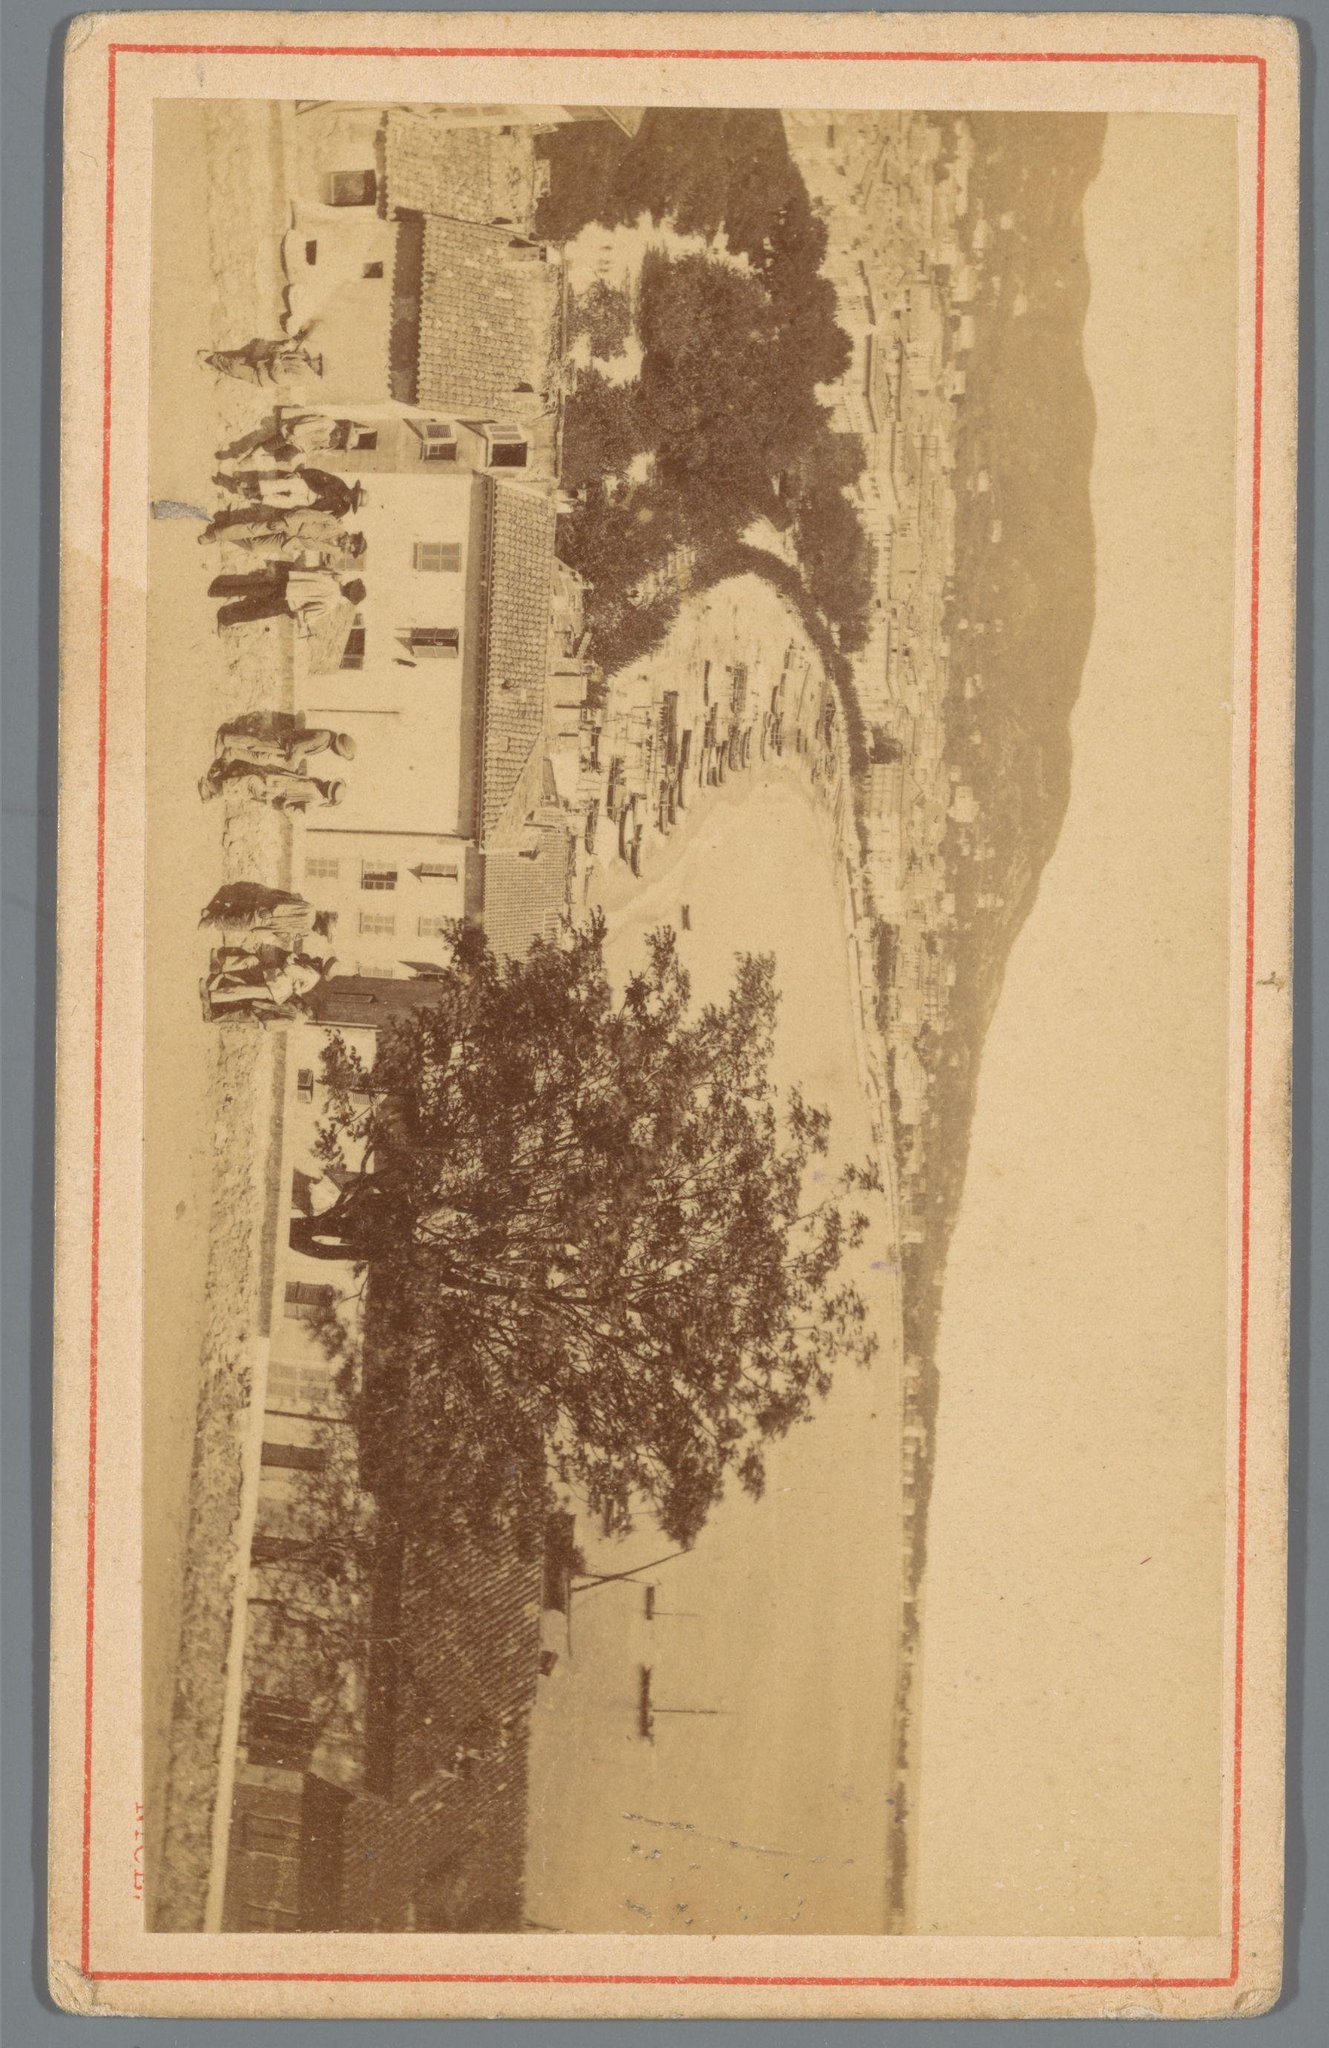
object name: photograph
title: Gezicht op Cannes en de Baai van Cannes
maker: eugène degand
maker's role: painter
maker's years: 1829-1911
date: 1871-1872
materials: cardboard, paper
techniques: albumen print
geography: cannes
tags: gulf, bay, city-view in general; 'veduta'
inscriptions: monogram: ‘ED’, inscription: ‘Cannes et le Méditerrannée/ A P. de Roo/ en souvenir de ses amis/ J. ten Cate Huender’, inscription: ‘E. Degand/ Peinture et photographie/ Rue Pastorelli/ derrière la Pension Millet/ et Rue Paradis, 6./ Nice/ Portraits/ Vues de Nice de toutes grandeurs’